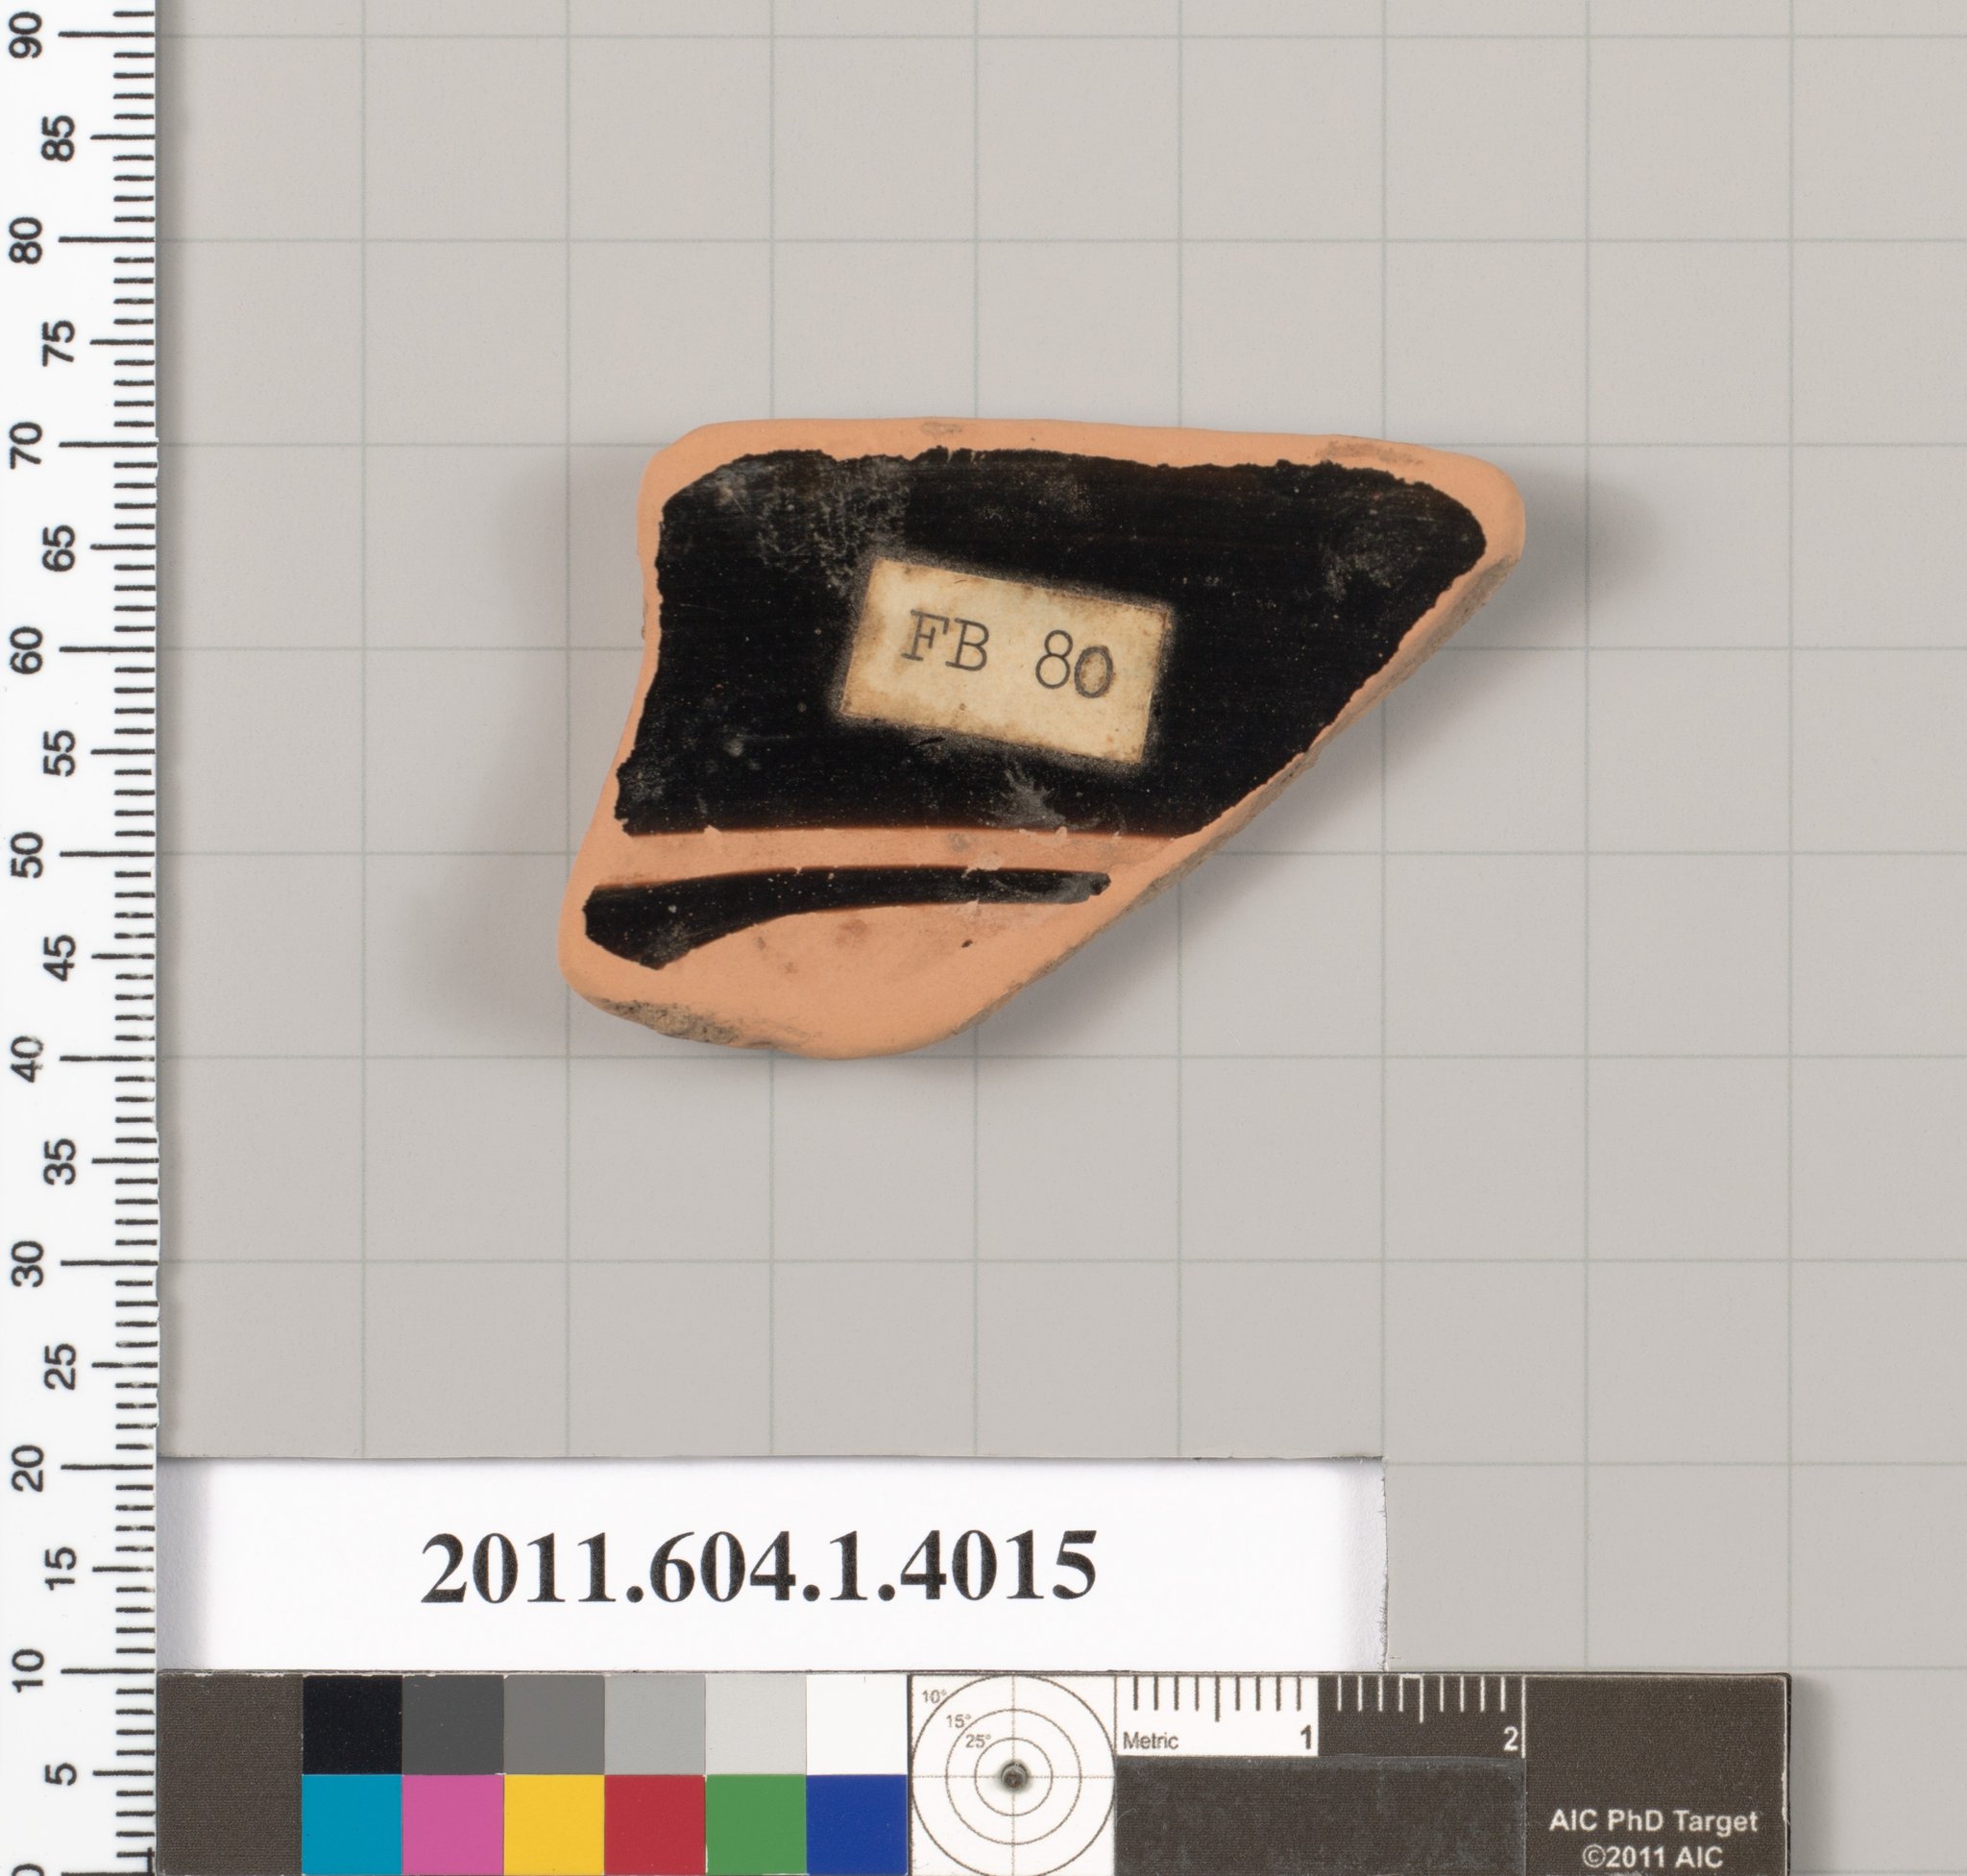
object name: kylix fragment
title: Terracotta rim fragment of a kylix (drinking cup)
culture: greek, attic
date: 460-440 BCE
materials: terracotta